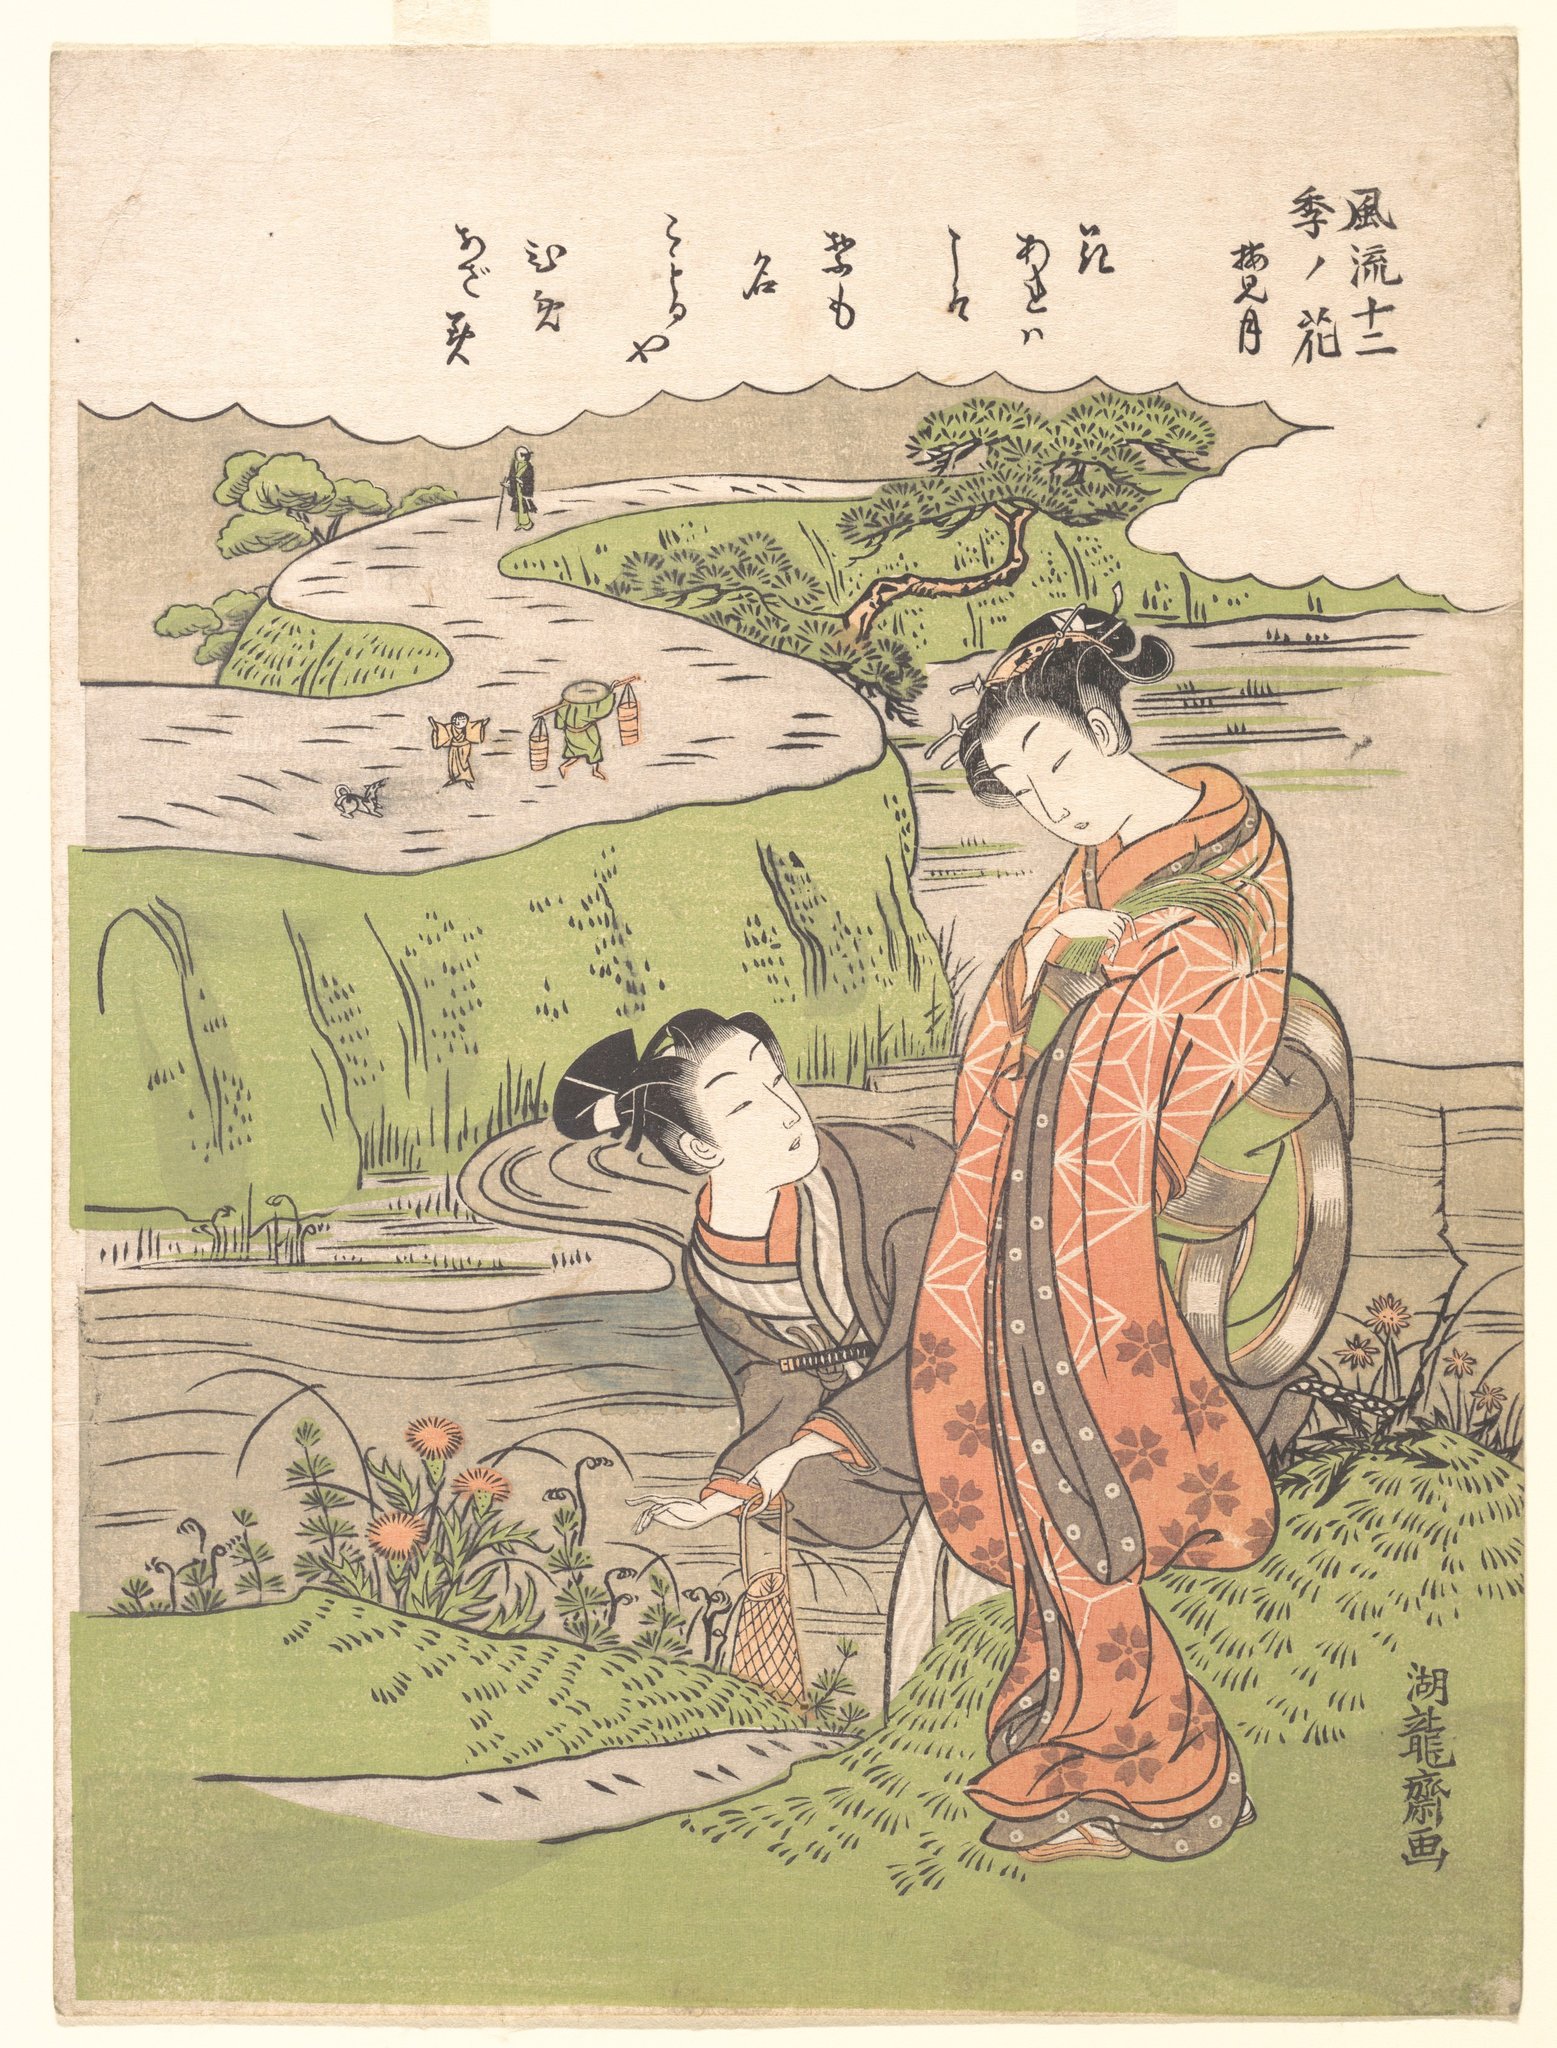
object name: print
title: Plum-Seeing Month: Second Month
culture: japanese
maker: isoda koryūsai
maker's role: artist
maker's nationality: japanese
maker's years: 1735-1790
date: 1735-1790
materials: ink, paper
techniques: woodblock print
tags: men,women,streams